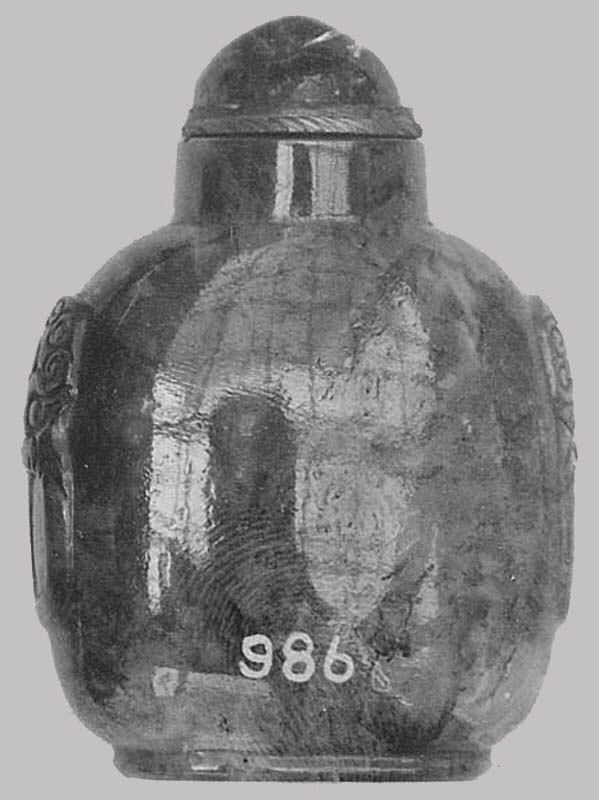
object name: snuff bottle with stopper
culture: chinese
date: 1701-1900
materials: stone, crystal